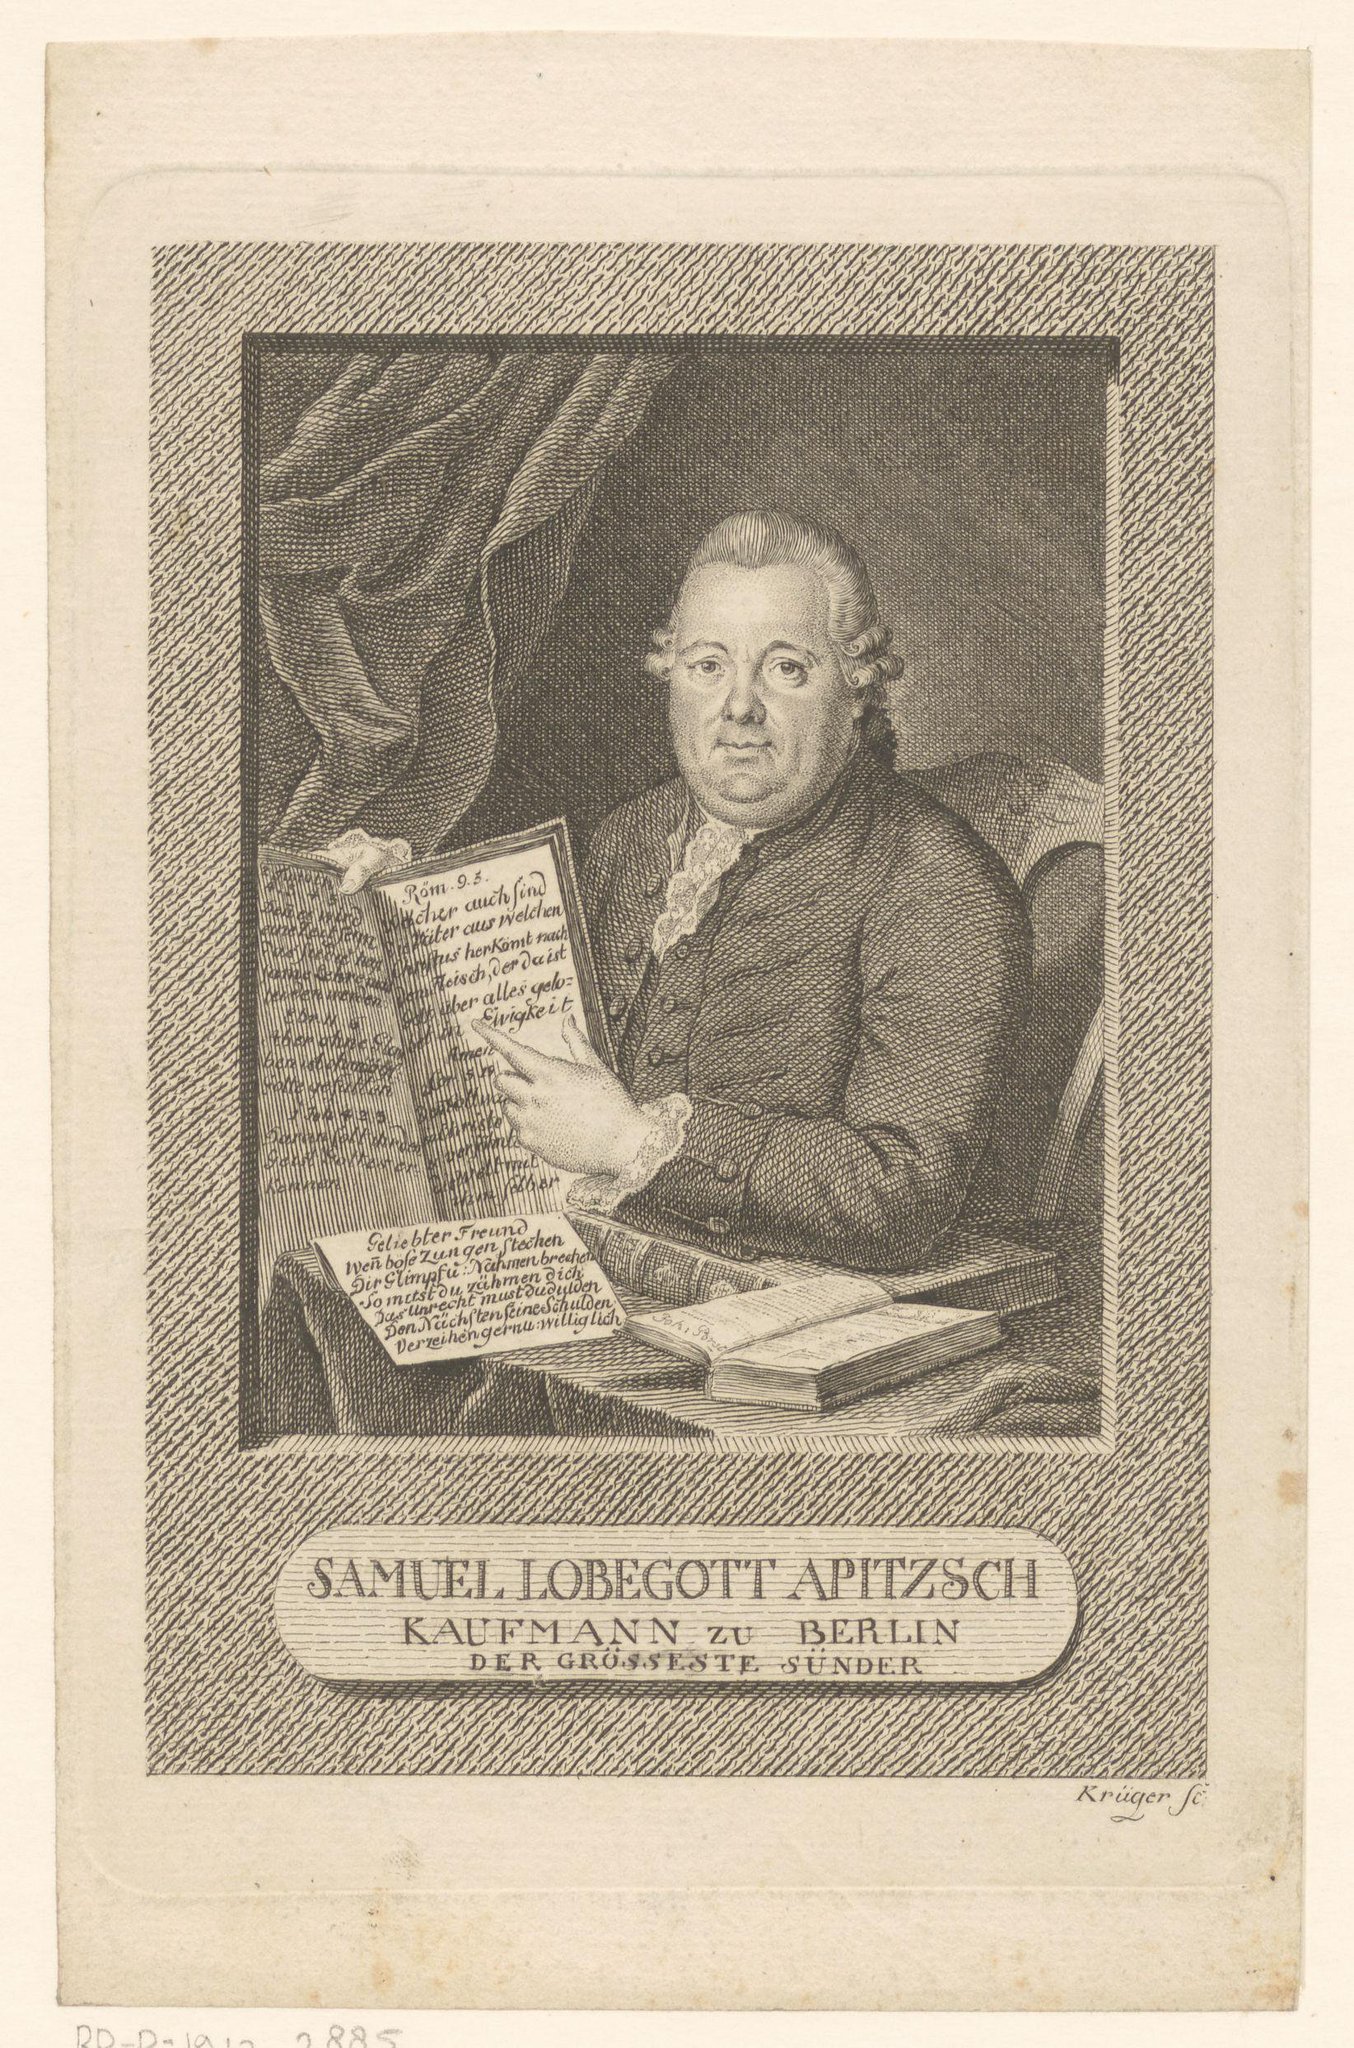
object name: print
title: Portret van Samuel Lobegott Apitzsch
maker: johann conrad krüger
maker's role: artist, painter, print maker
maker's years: 1733-1791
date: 1743-1791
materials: paper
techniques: engraving, etching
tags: historical persons, portrait of a writer, book, merchant, salesman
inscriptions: collector's mark: Lugt 2228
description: Tekst in het Duits in de ondermarge en in de boeken in de voorstelling.